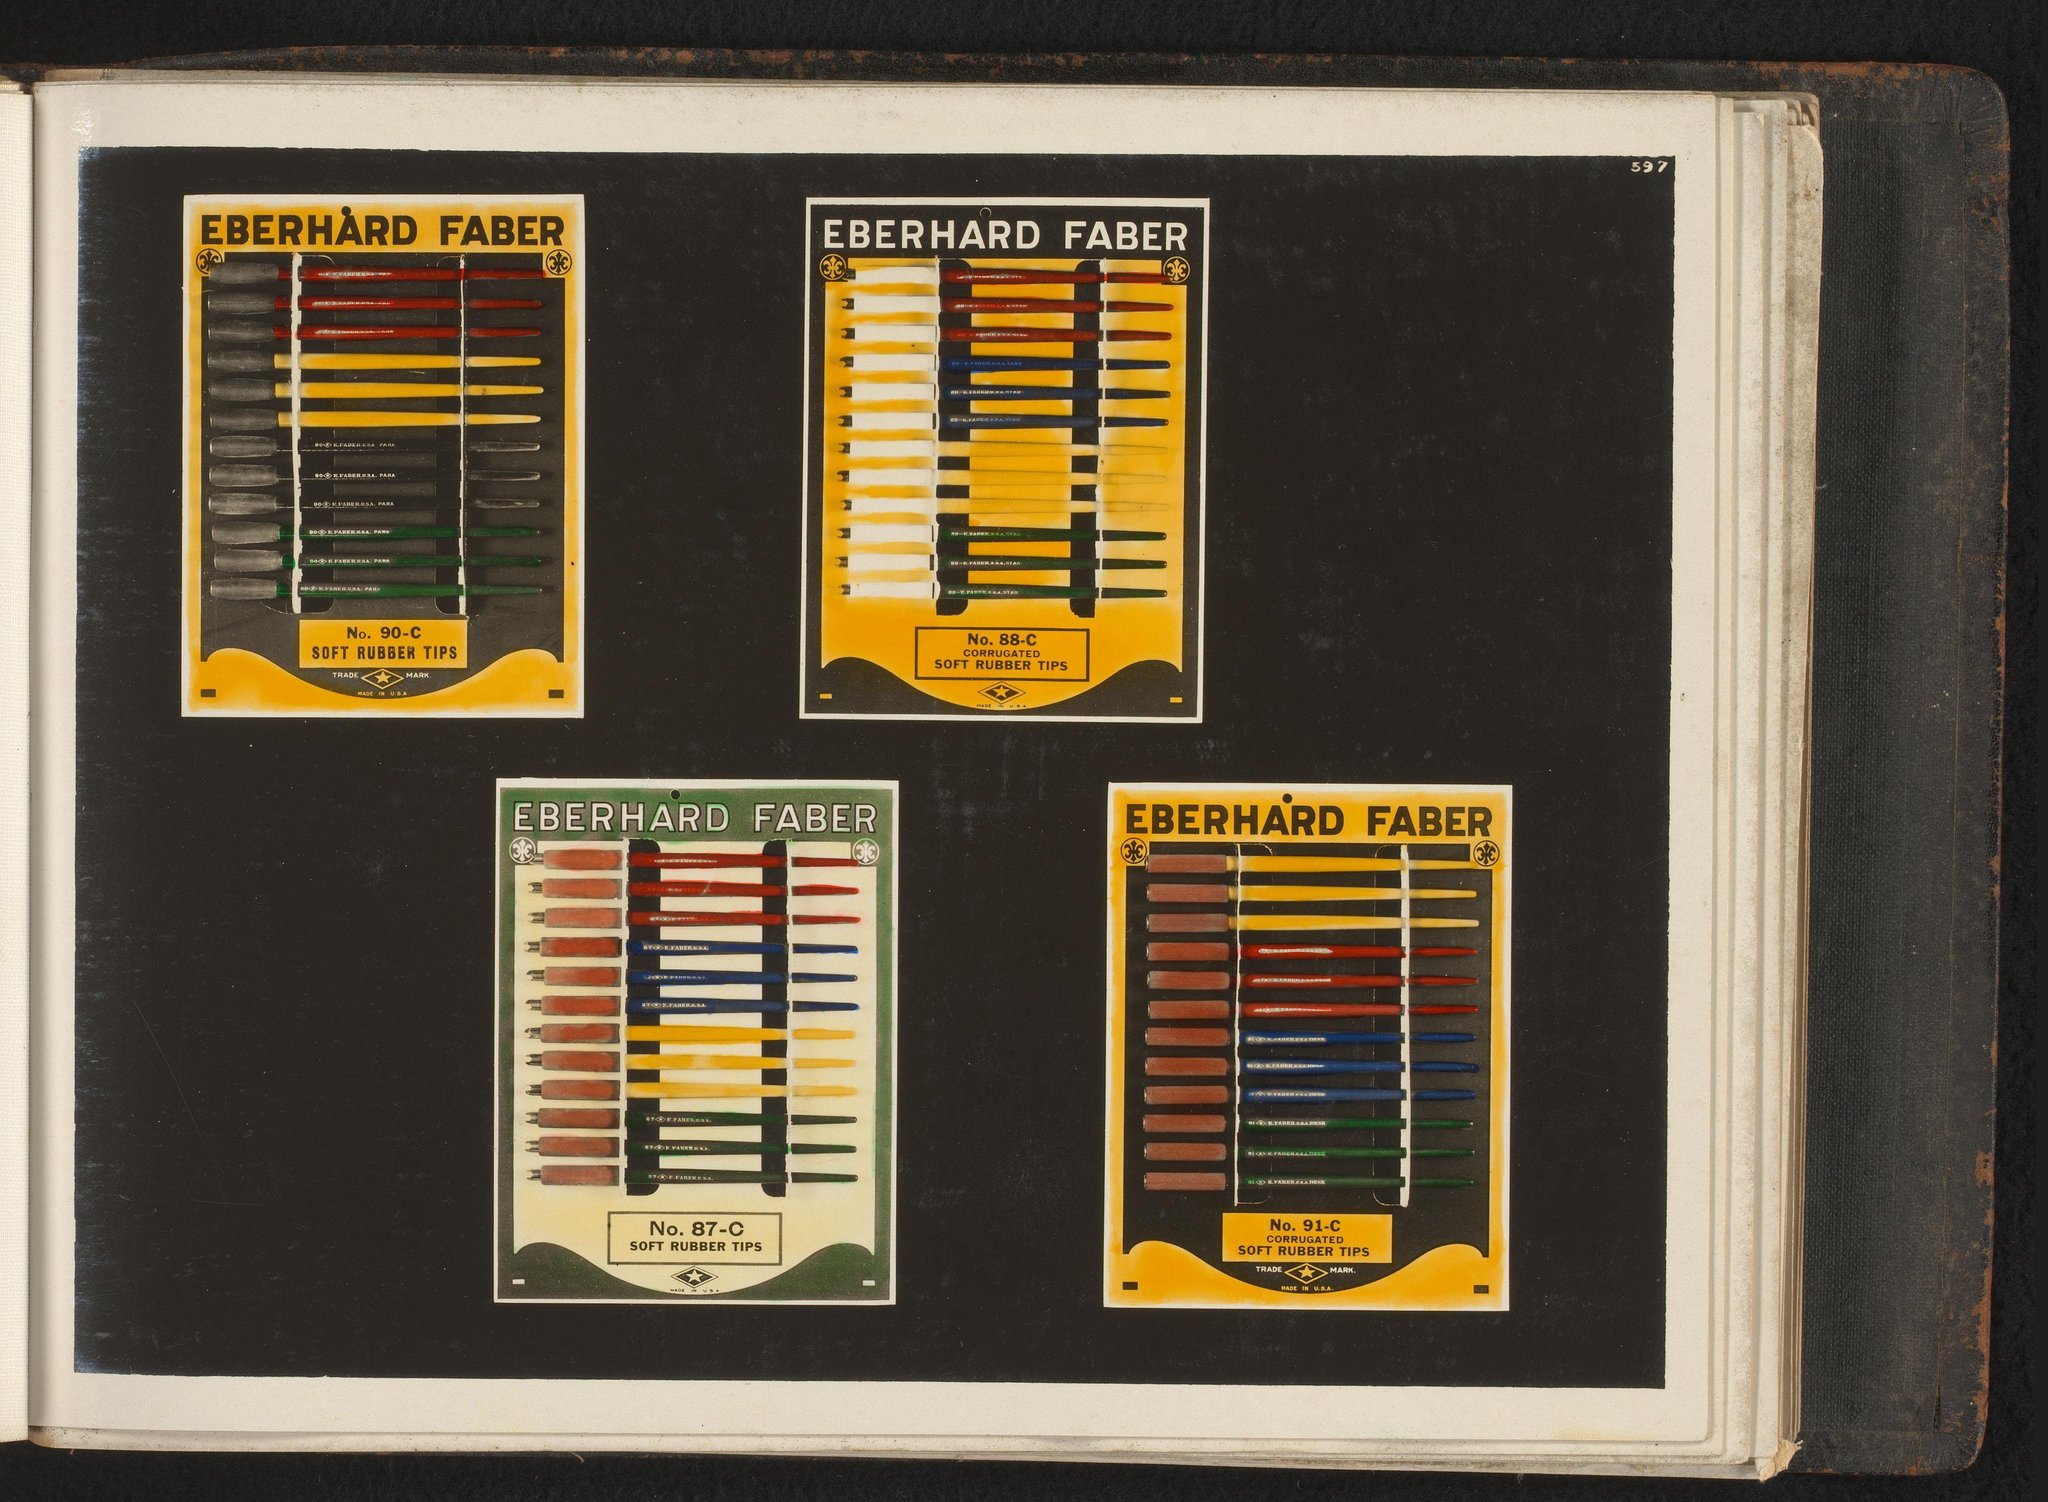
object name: album leaf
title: Sets met potloden van Eberhard Faber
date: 1915-1935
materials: paper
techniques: gelatin silver print, hand coloring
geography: springfield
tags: pencil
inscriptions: number: ‘597’, stamp: ‘Paramount/ Commercial Studios/ 145 Chestnut St./ Springfield - Mass.’